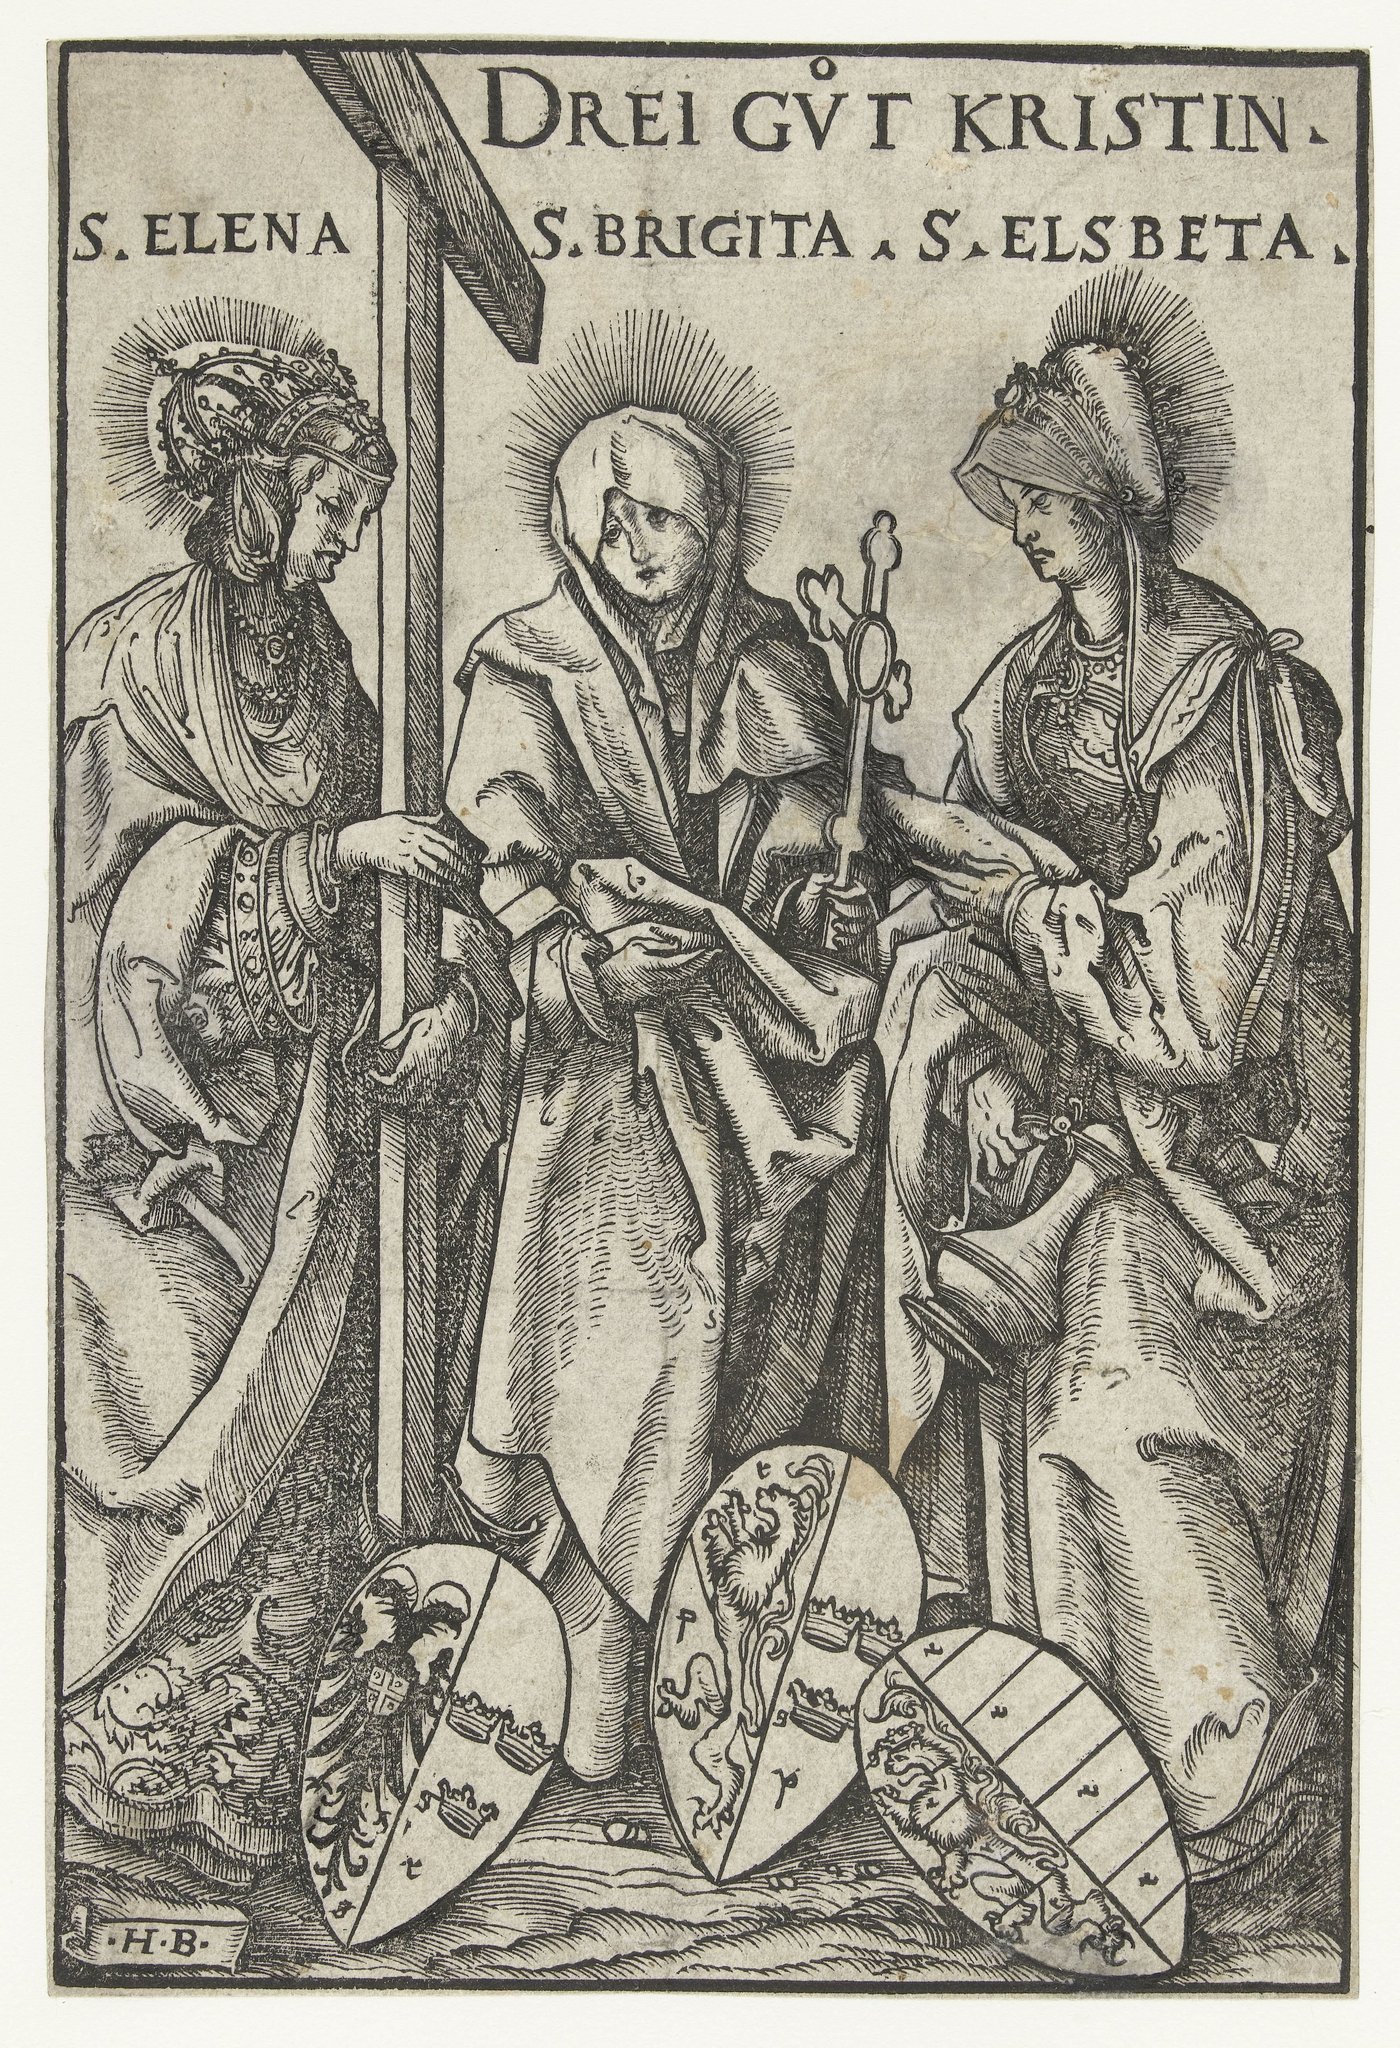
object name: print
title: Heilige Helena, heilige Brigita van Zweden en heilige Elisabet van Hongarije als drie beste christelijke vrouwen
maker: hans burgkmair (i)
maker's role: draughtsman, print maker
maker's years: 1473-1531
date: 1516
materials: paper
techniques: woodcut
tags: empress helena, mother of constantine the great; possible attributes: model of church, (royal) crown, crown of thorns, cross, three nails, men of name or fame, heroes, 'homines illustres', 'uomini famosi' - aa - women of name or fame, heroines, 'femmes célèbres', 'les neuf preuses', the wife and widow of the landgrave of thuringia, and franciscan tertiary, elisabeth of hungary; possible attributes: beggar, cripple, fish, loaves, leper, model of church, pitcher, roses in lap, scald-head, three crowns, the foundress of the order of bri(d)gettines, the widow bridget (birgitta) of sweden; possible attributes: band over veil with five red spots, book, candle, heart with cross, inkhorn, pilgrim's hat, staff, wallet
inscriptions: collector's mark: Lugt 2228a, collector's mark: Lugt 1185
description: Heilige Helena met een groot kruis, heilige Brigita van Zweden met een klein kruis en heilige Elisabet van Hongarije met een kan in haar hand. Deze drie vrouwen zijn voorgesteld als de drie beste christelijke vrouwen zoals uit de Duitse tekst blijkt. Op de grond staan de schilden met de wapens van hun families.